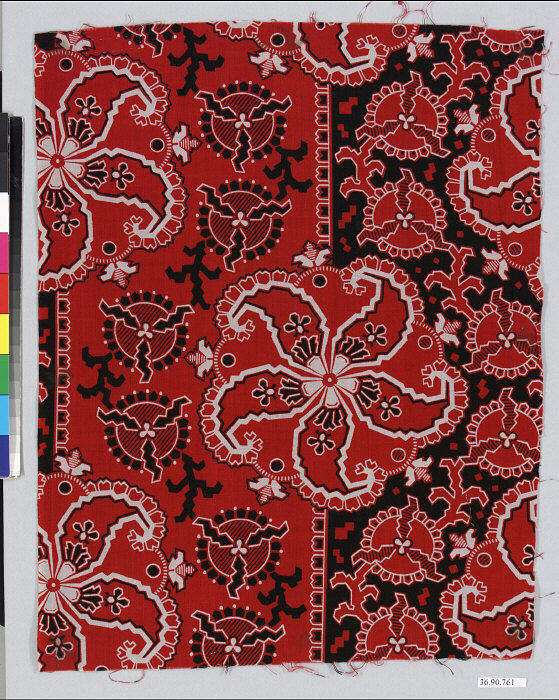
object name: piece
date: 1867-1900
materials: cotton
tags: flowers